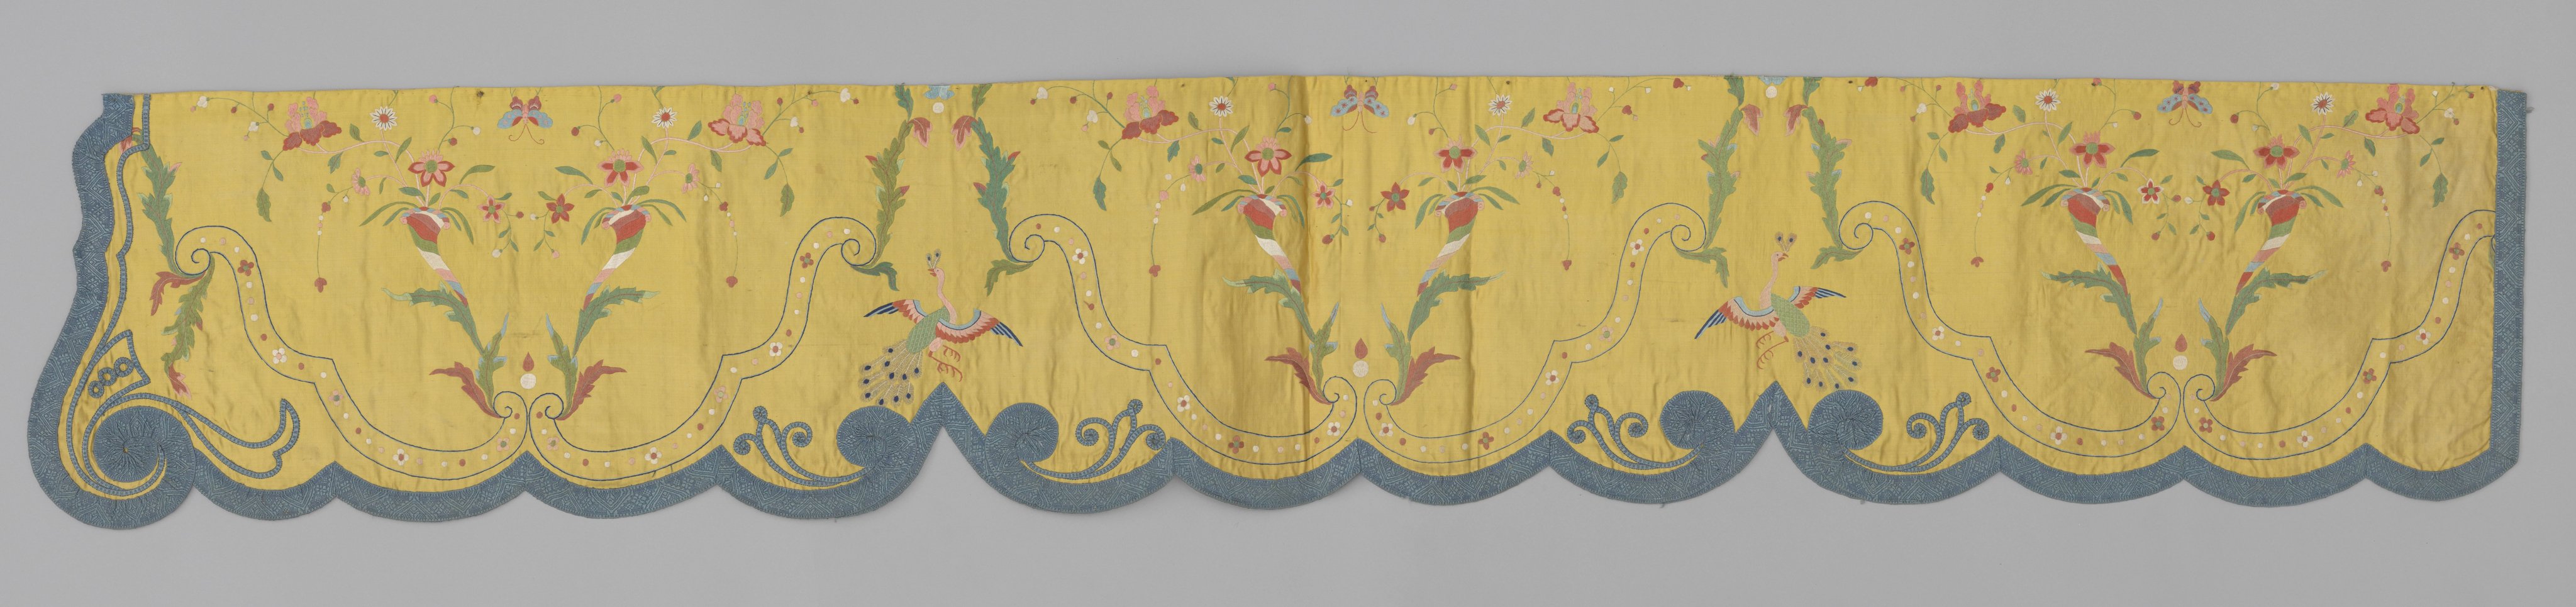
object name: bed covering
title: Matrasomhang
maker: Anonymous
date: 1720-1740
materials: linen, silk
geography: guangdong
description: Geel zijden matrasomhang van een bedgarnituur geborduurd met pauwen, bloemen, vlinders, hoorns van overvloed in veelkleurige zijde, omboord en versierd met blauw passement, gevoerd met grof linnen. Bestemd voor rechterkant van het bed.